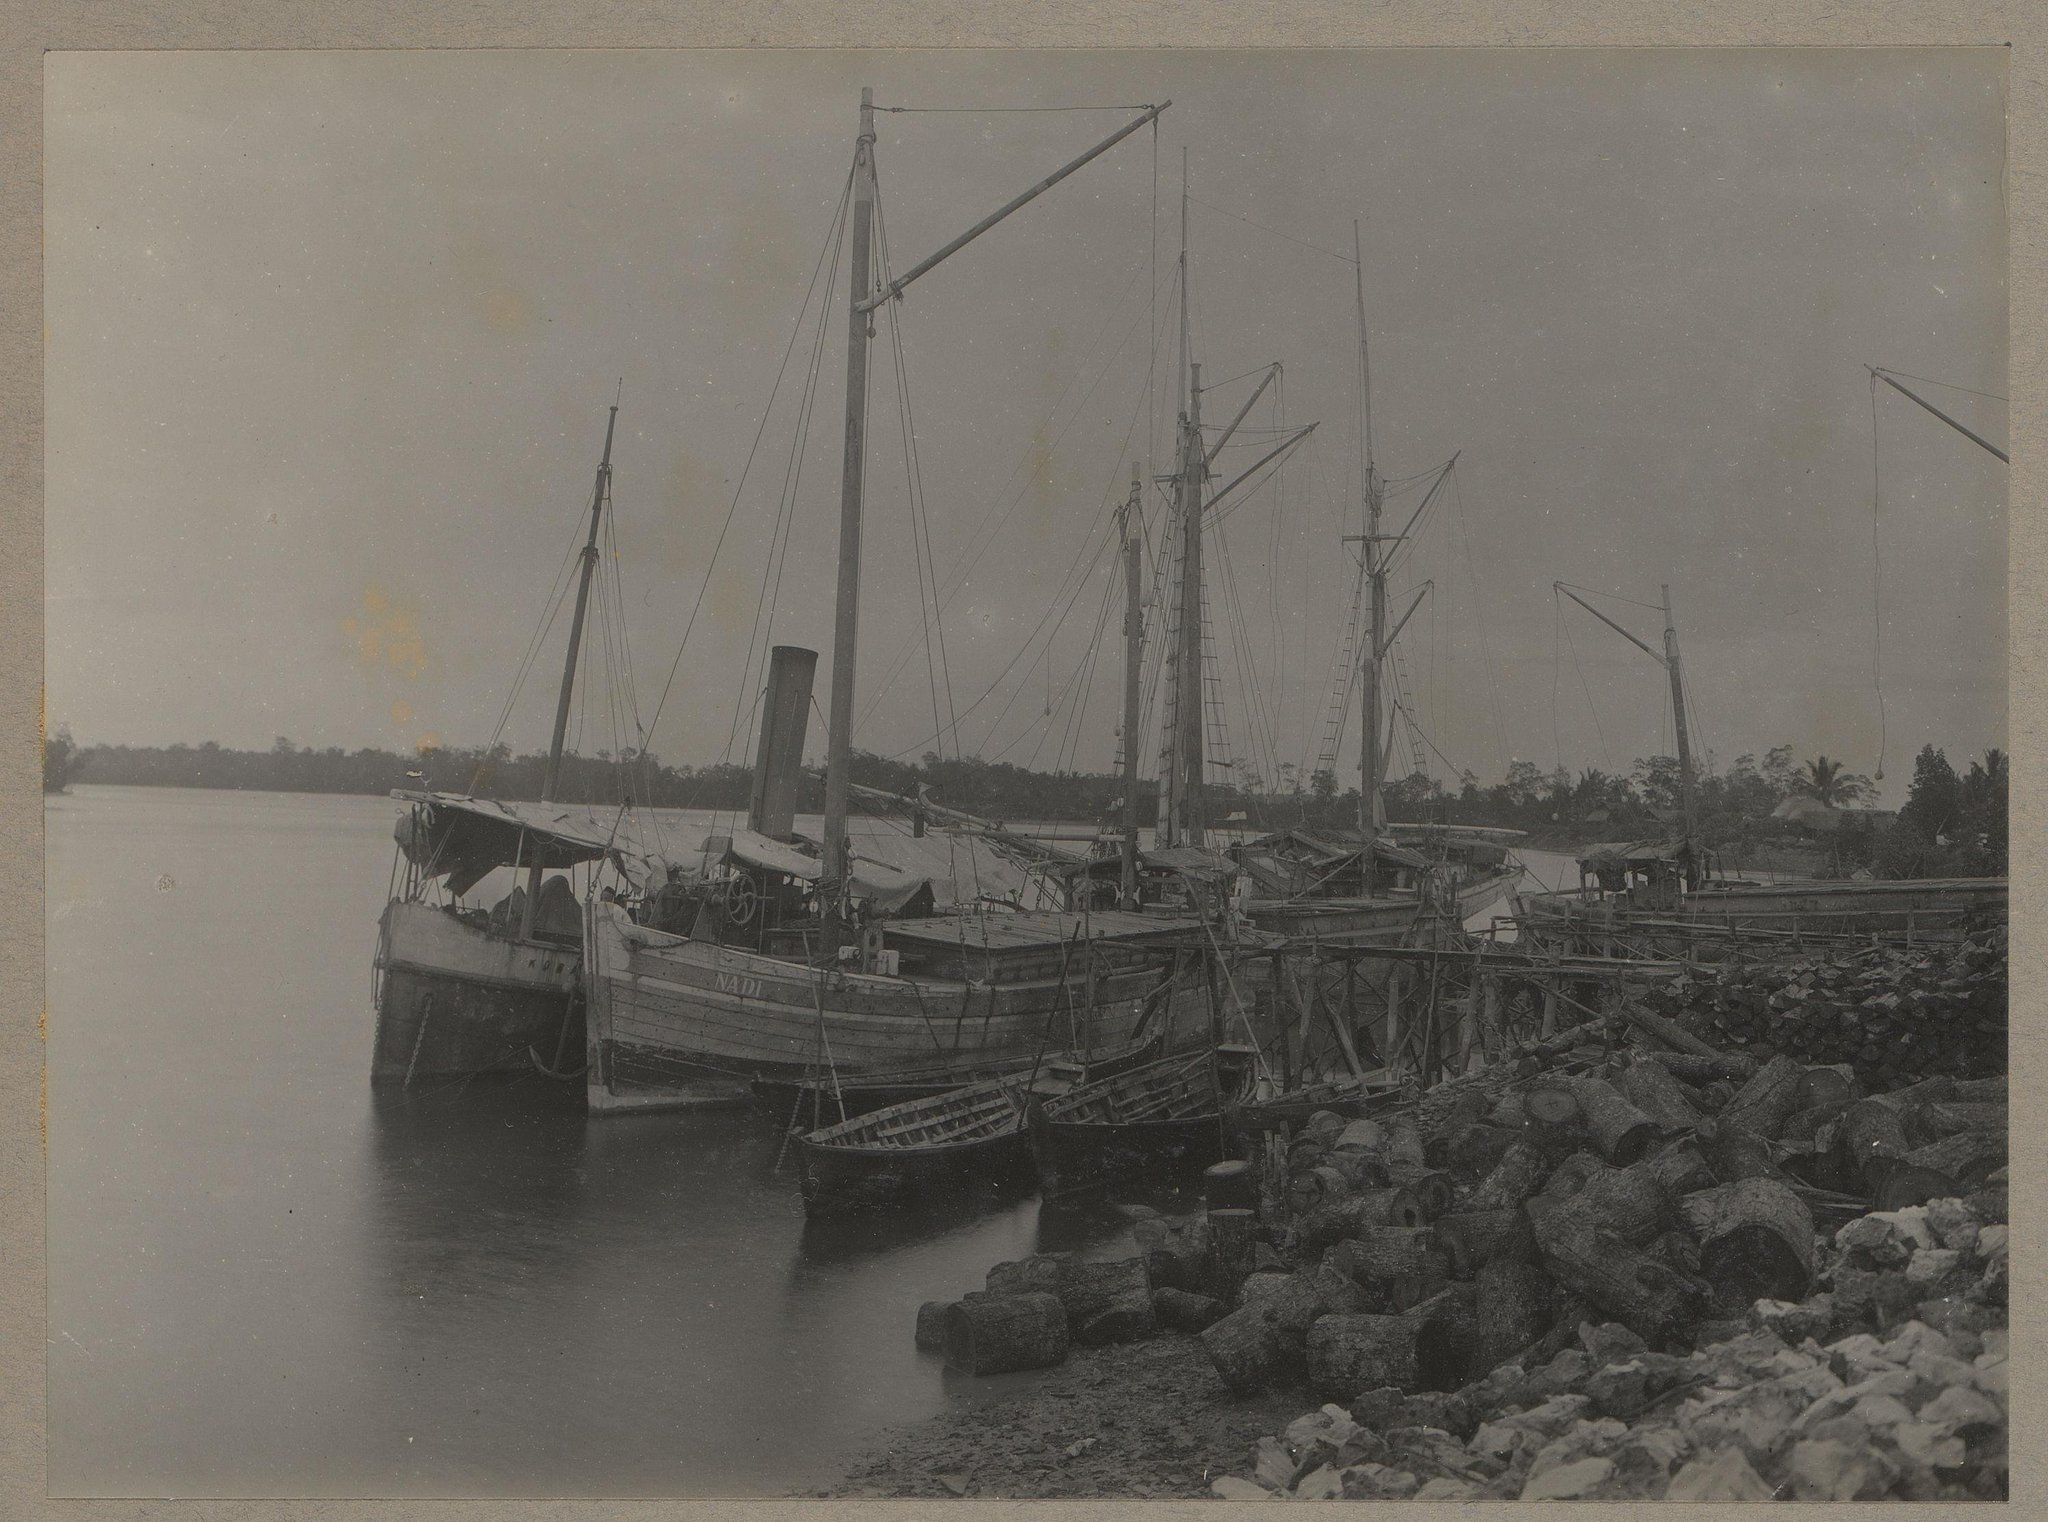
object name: photograph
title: Pangkalbalam. s.s. Koba en de prauw Nadi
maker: Anonymous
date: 1914-1919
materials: photographic support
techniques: gelatin silver print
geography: bangka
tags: robert julius boers, colonial system, mining, transport of timber, timber-trailer, steamship, motorship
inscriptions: inscription: ‘Pangkalbalam. s.s. Koba en de prauw Nadi’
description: Enkele boten, waaronder het stoomschip Koba en de prauw Nadi, aan de kade te Pangkalbalam. Op de wal liggen stapels brandhout. Onderdeel van het fotoalbum aangeboden aan Robert Julius Boers bij zijn vertrek naar Nederland in 1919 door het personeel van de Banka-tinwinning.